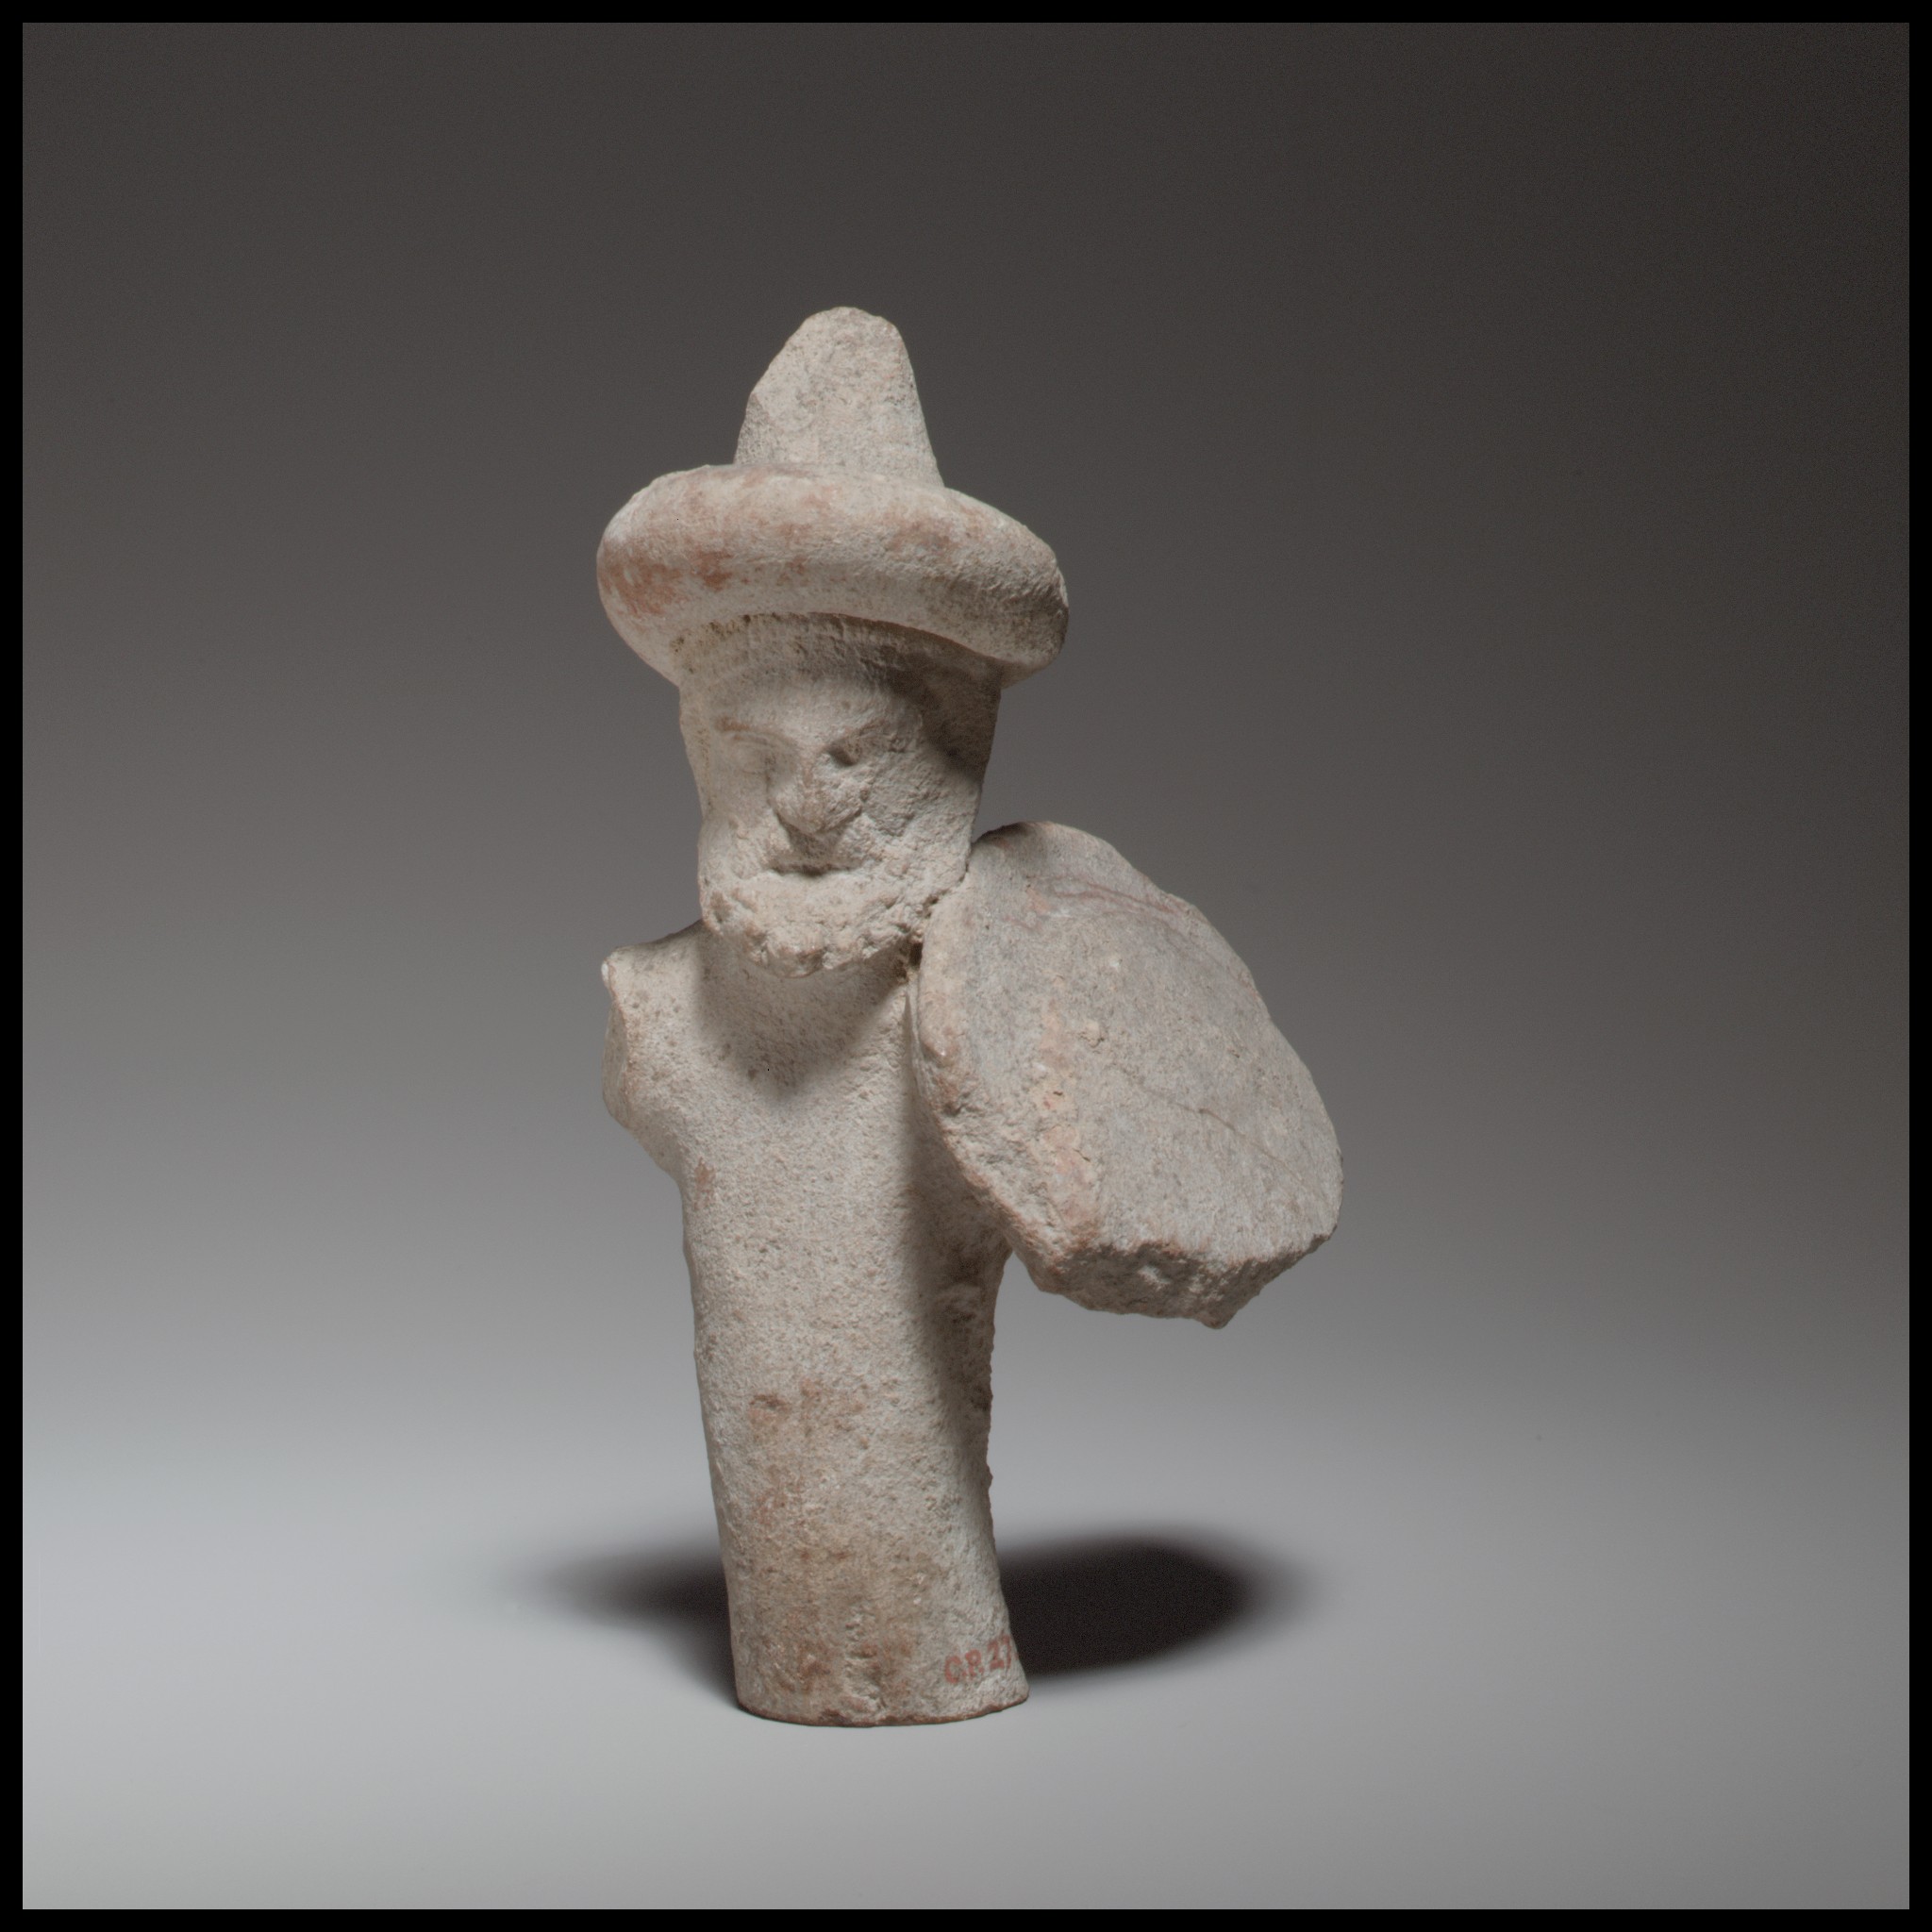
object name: statue of a warrior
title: Horseman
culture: cypriot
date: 400-201 BCE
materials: terracotta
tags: men